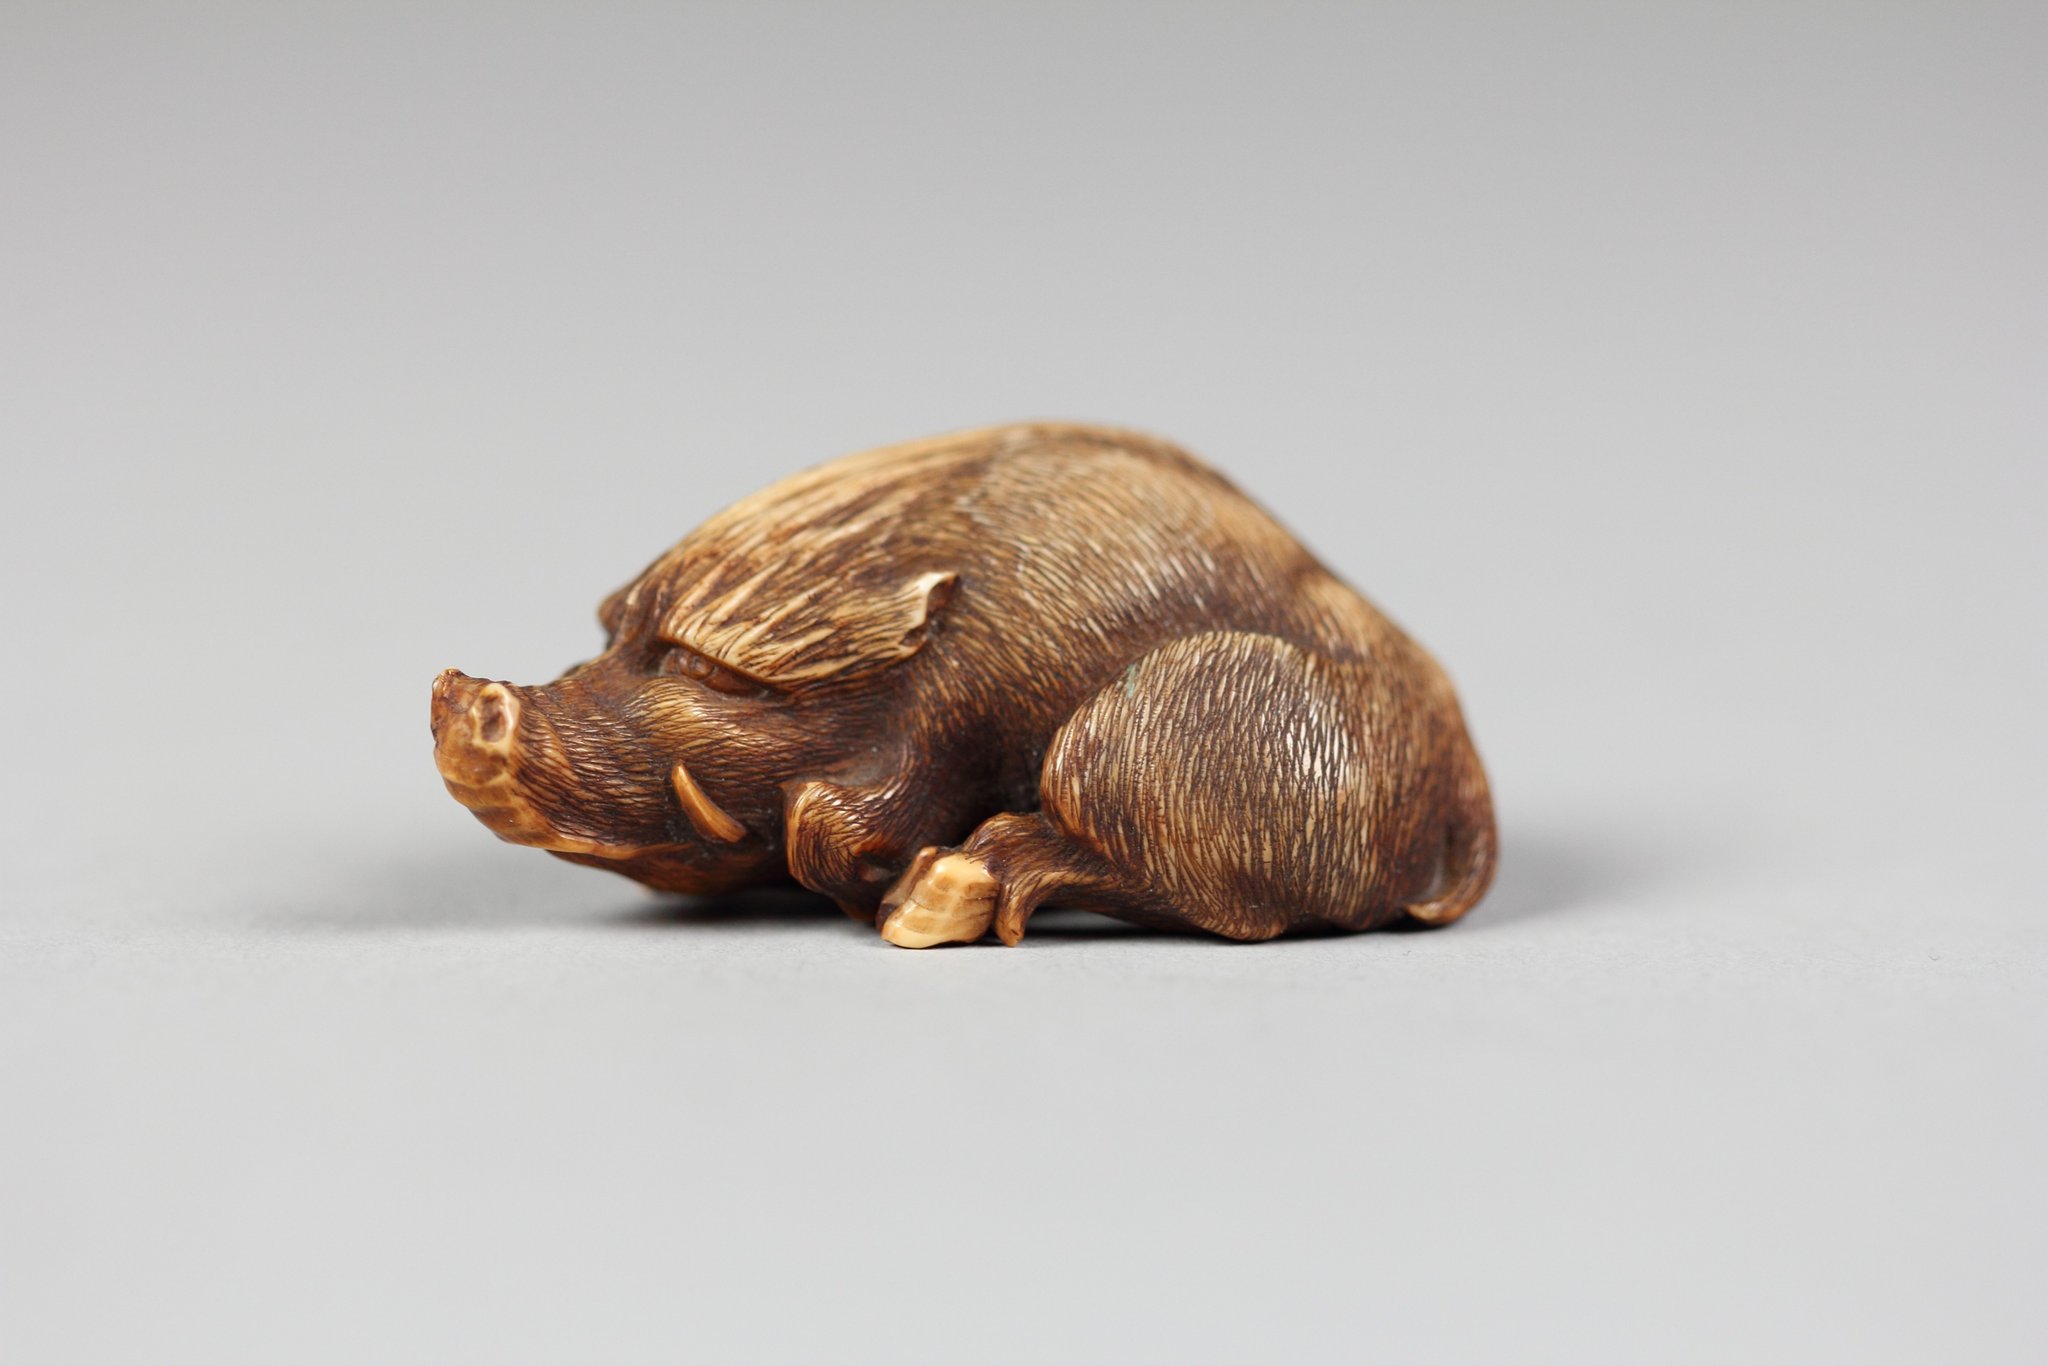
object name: netsuke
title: Boar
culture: japanese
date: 1801-1900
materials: ivory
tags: boars